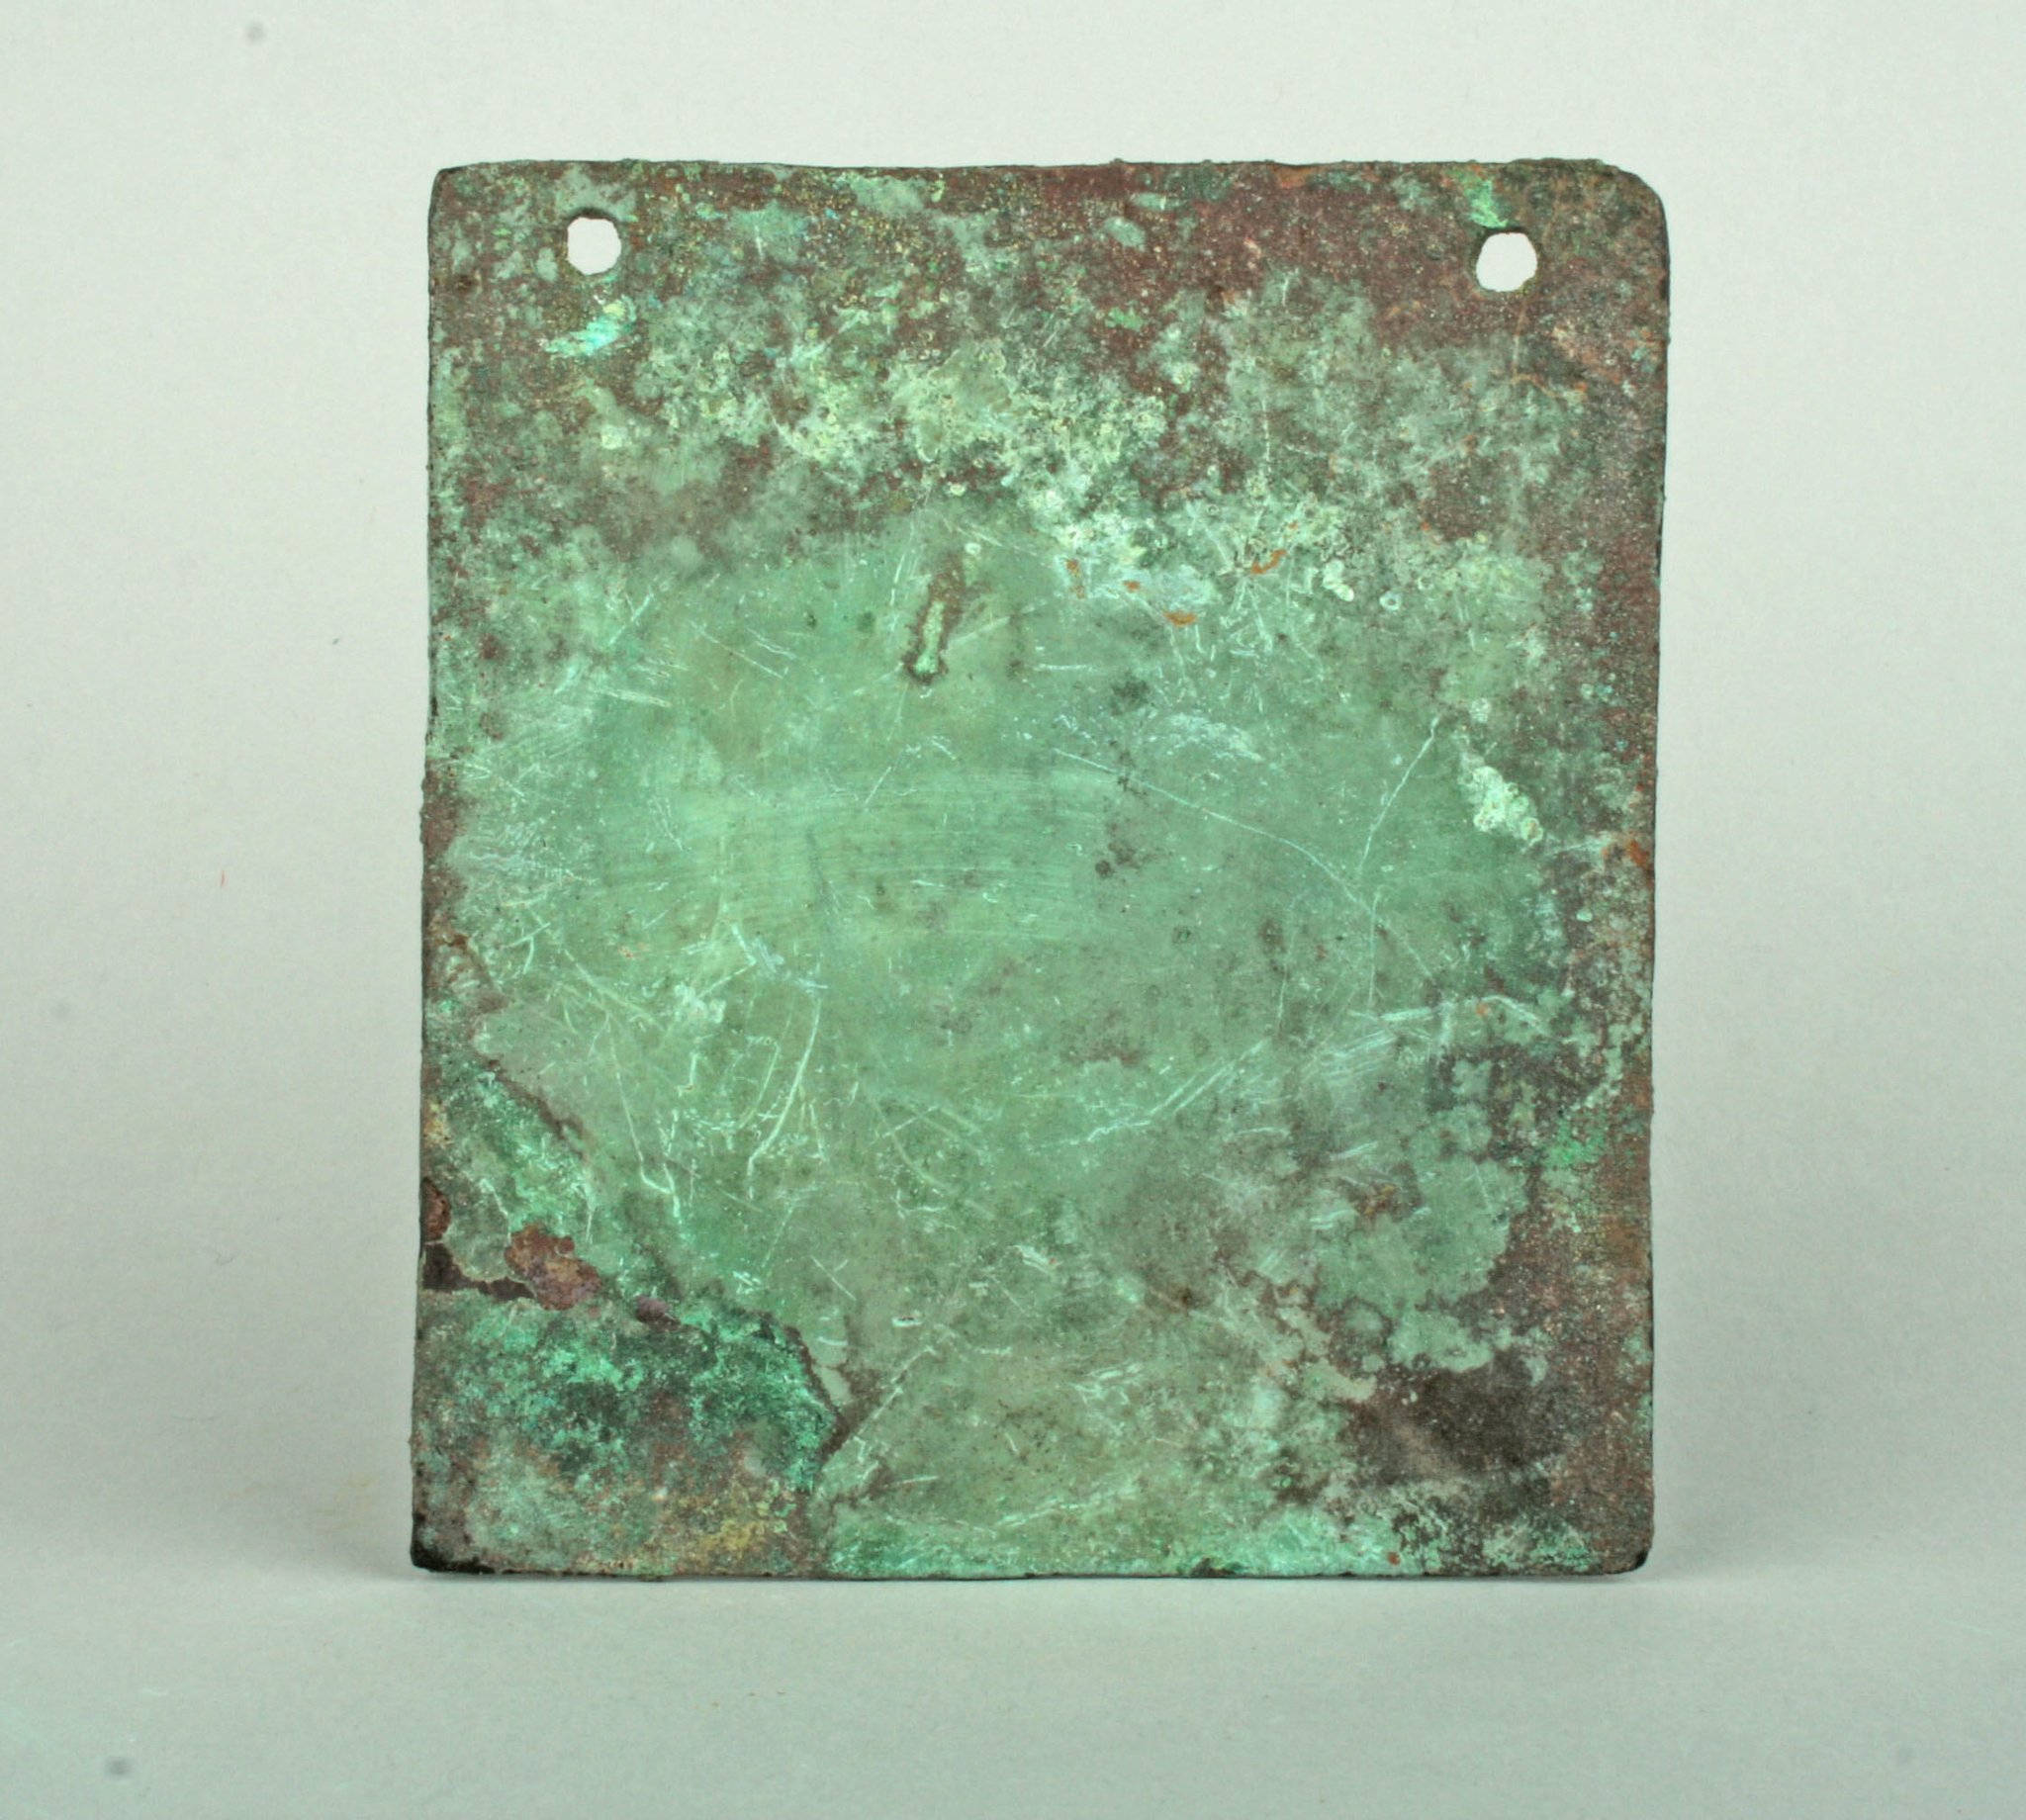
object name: plaque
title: Square Plaque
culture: vicús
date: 300 BCE-200 CE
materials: copper, gilt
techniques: hammering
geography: peru